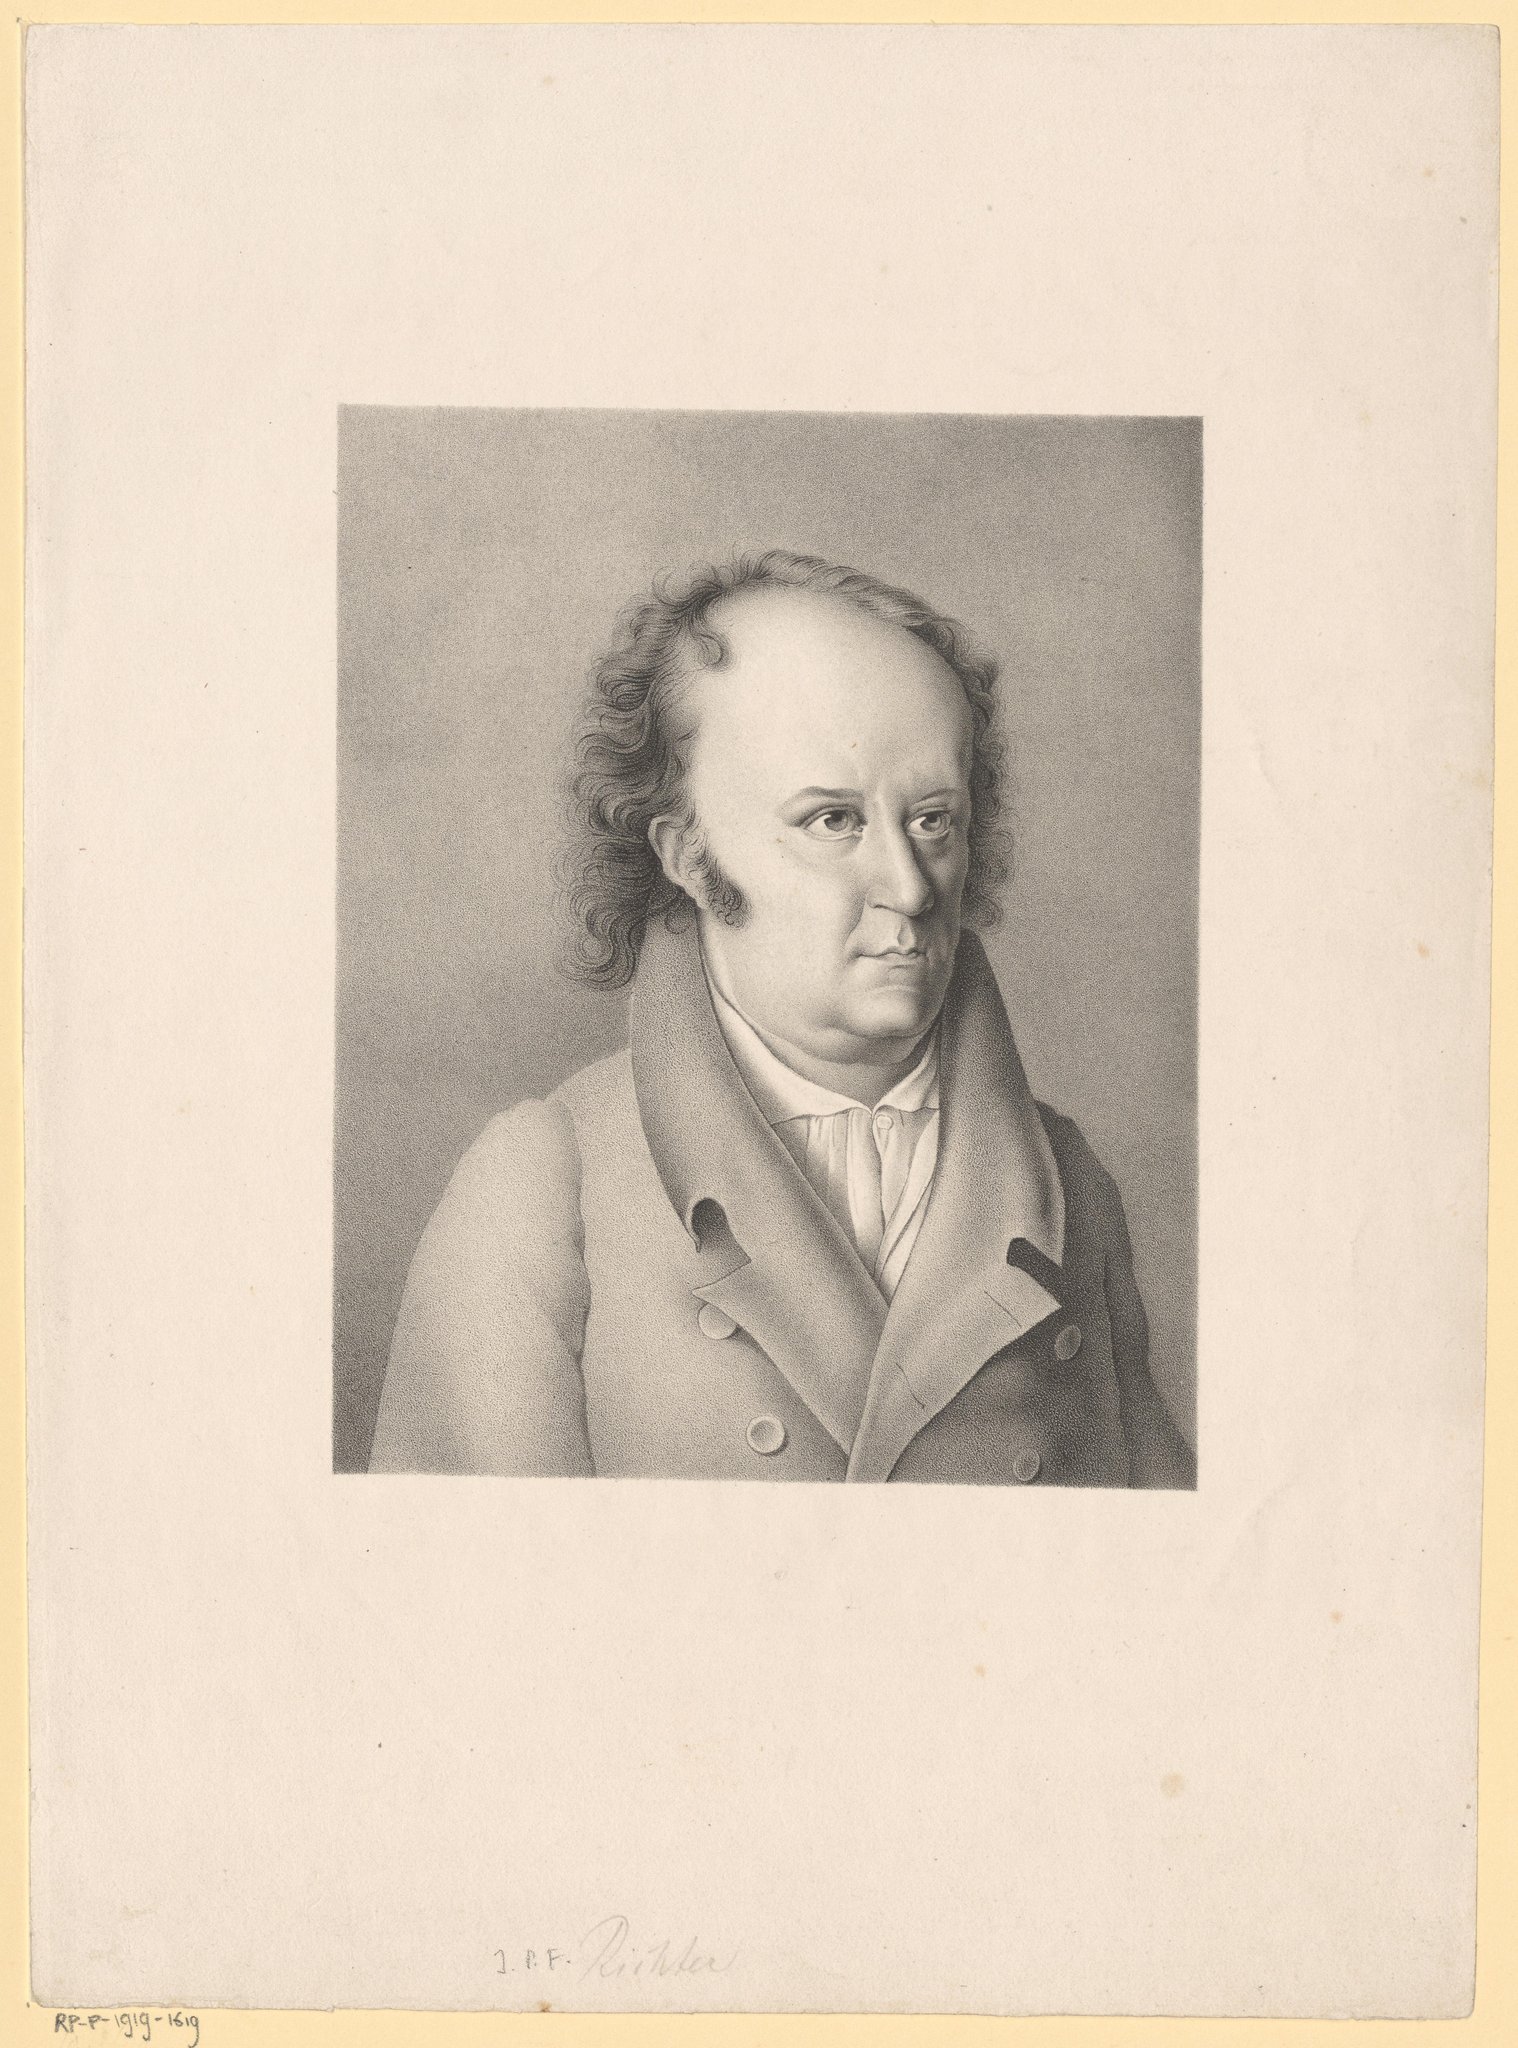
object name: print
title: Portret van Jean Paul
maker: Anonymous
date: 1795-1899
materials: paper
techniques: lithograph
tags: jean paul, historical persons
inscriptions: collector's mark: Lugt 2228